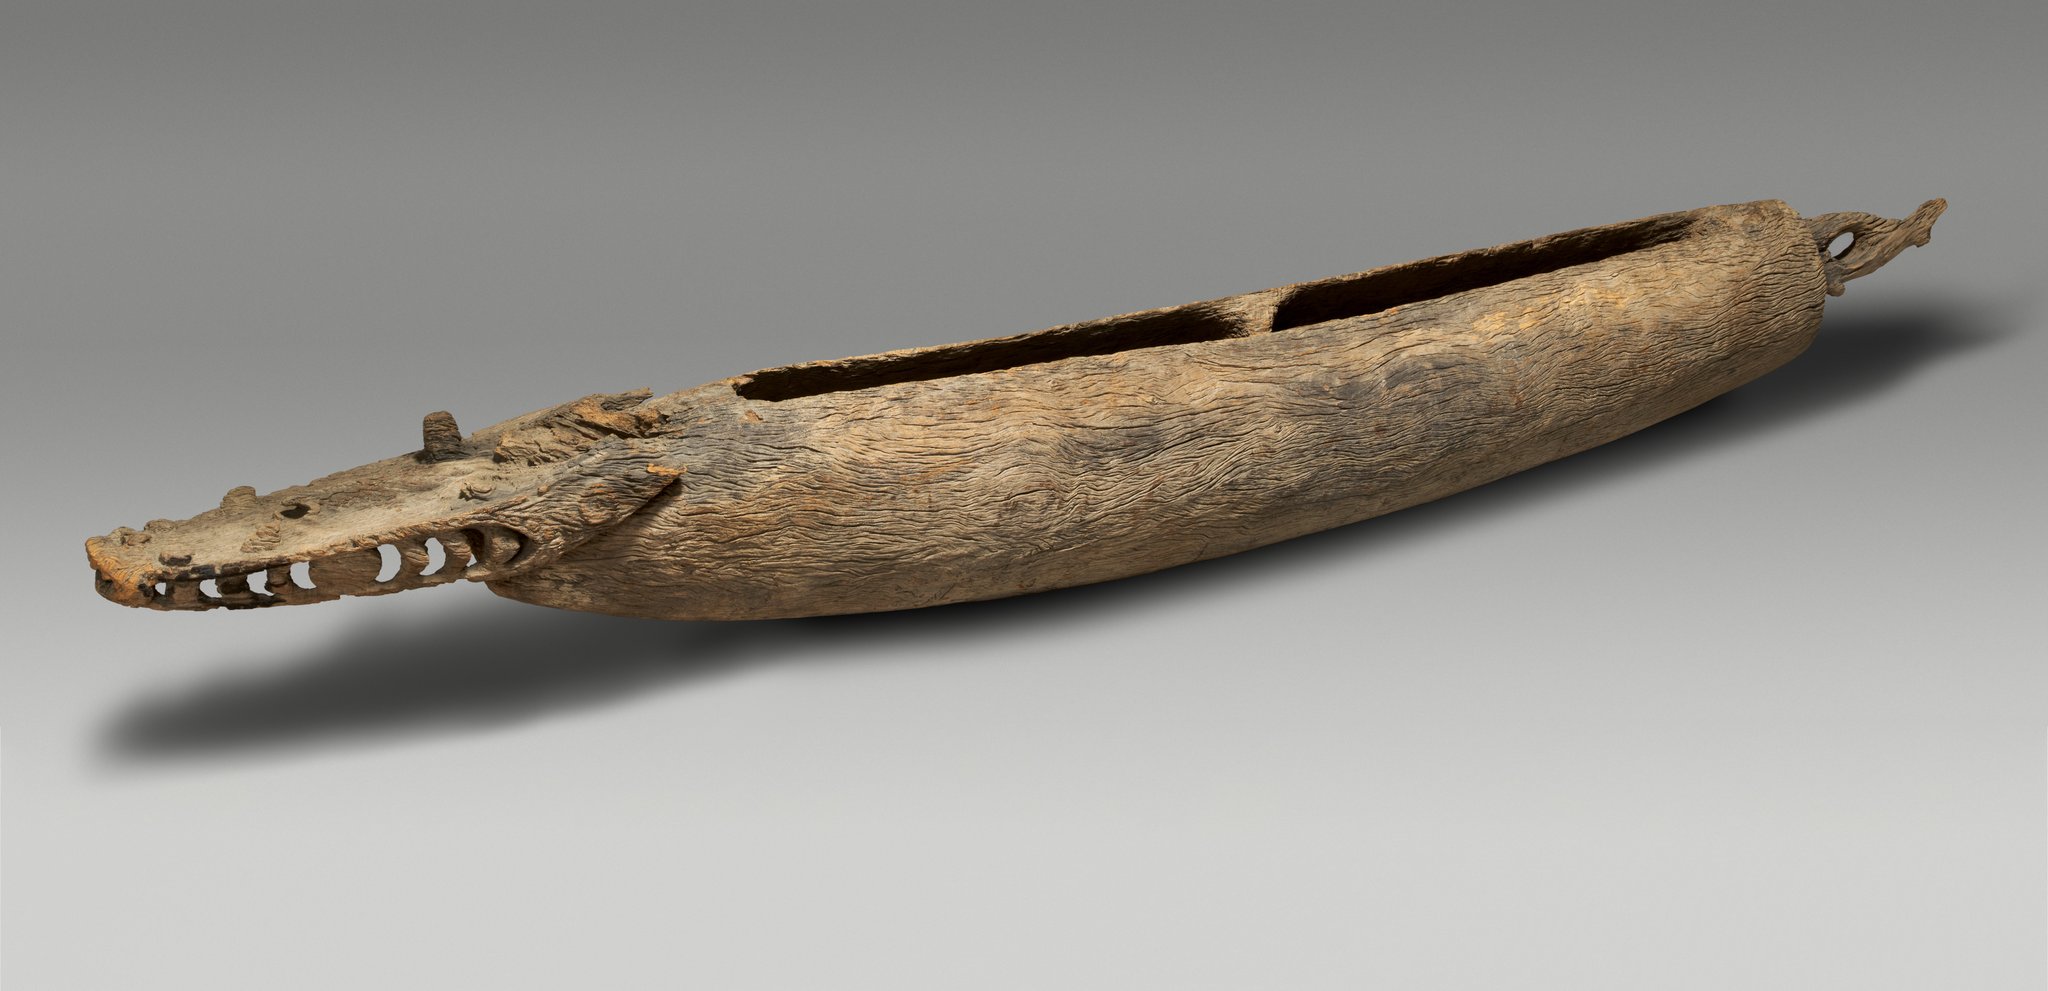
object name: slit gong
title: Sacred Slit Gong (Waken)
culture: iatmul people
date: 1801-1900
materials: wood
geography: papua new guinea